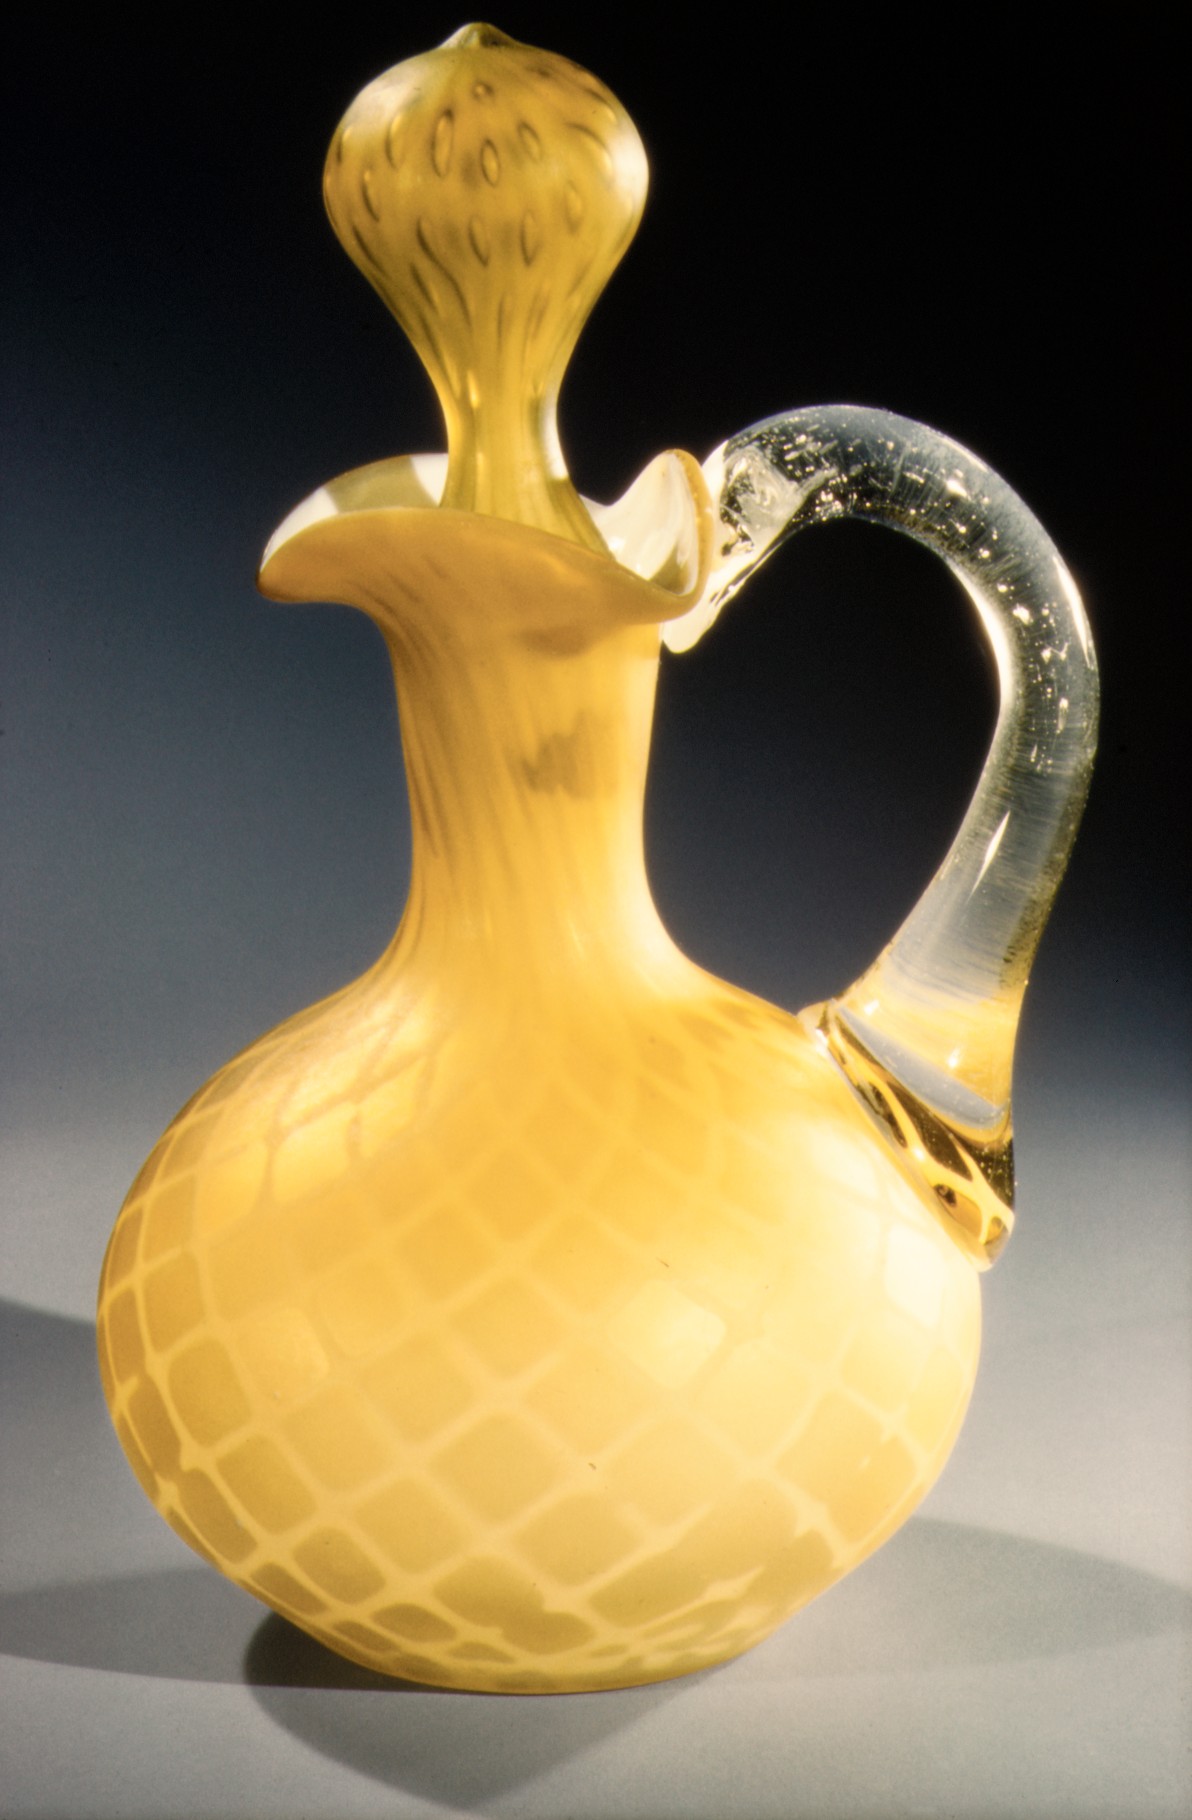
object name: cruet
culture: american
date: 1885-1890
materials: amber, glass, textile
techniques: glassblowing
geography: united states